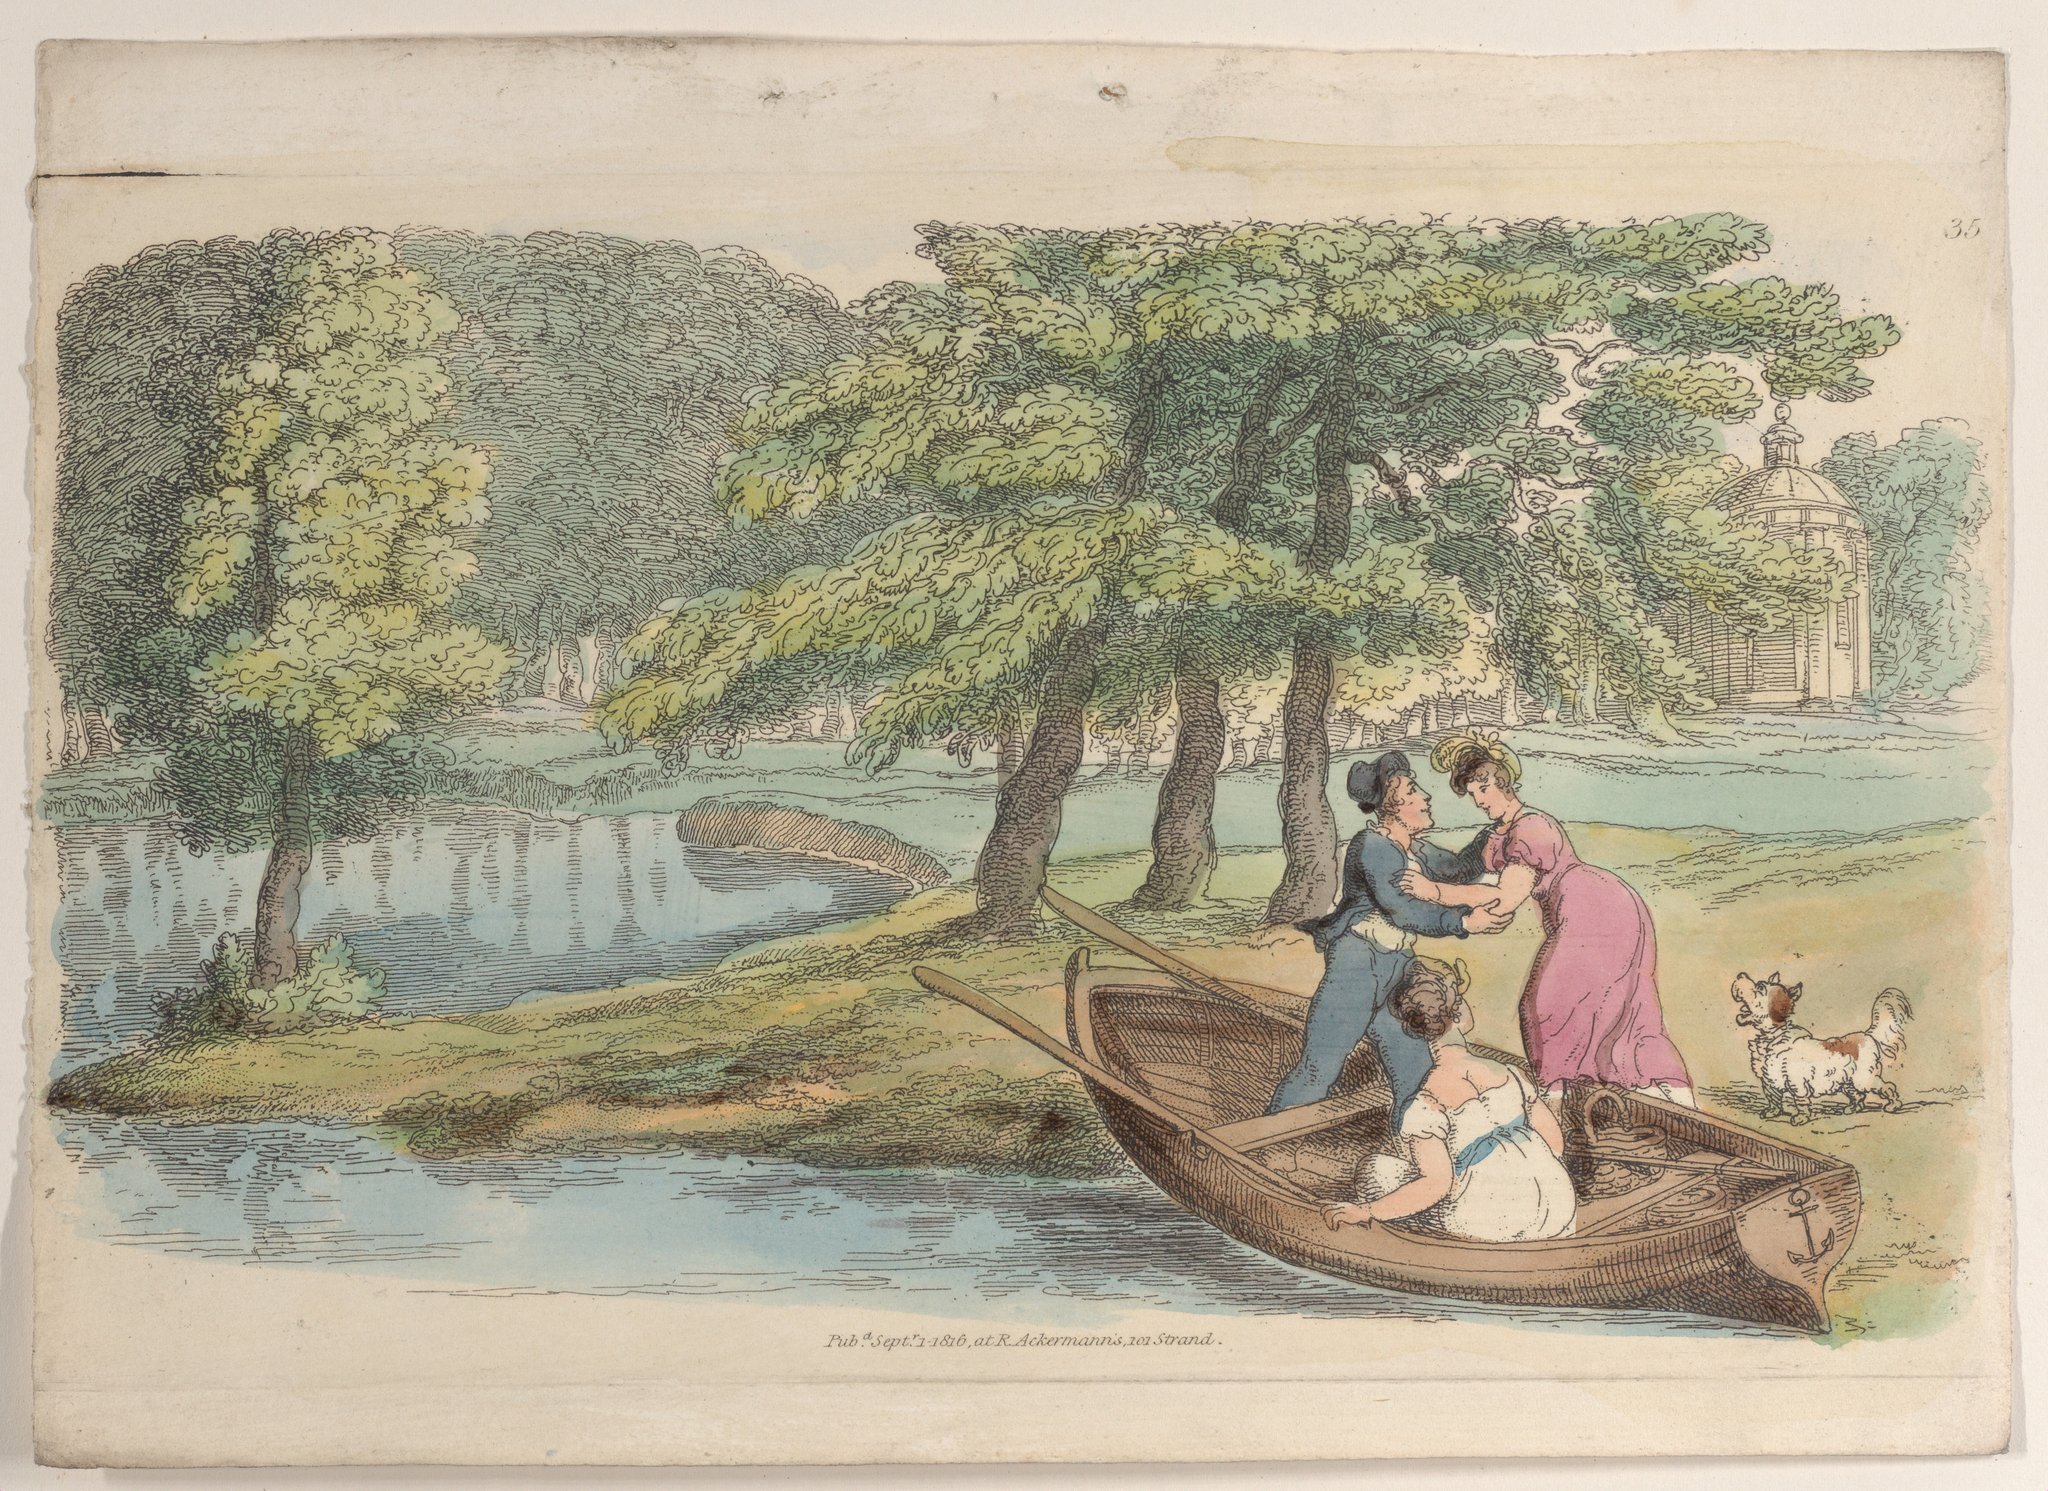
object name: print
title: Plate 35, from "World in Miniature"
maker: thomas rowlandson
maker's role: artist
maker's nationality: british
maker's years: 1757-1827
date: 1816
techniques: etching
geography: london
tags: men,women,dogs,rivers,boats